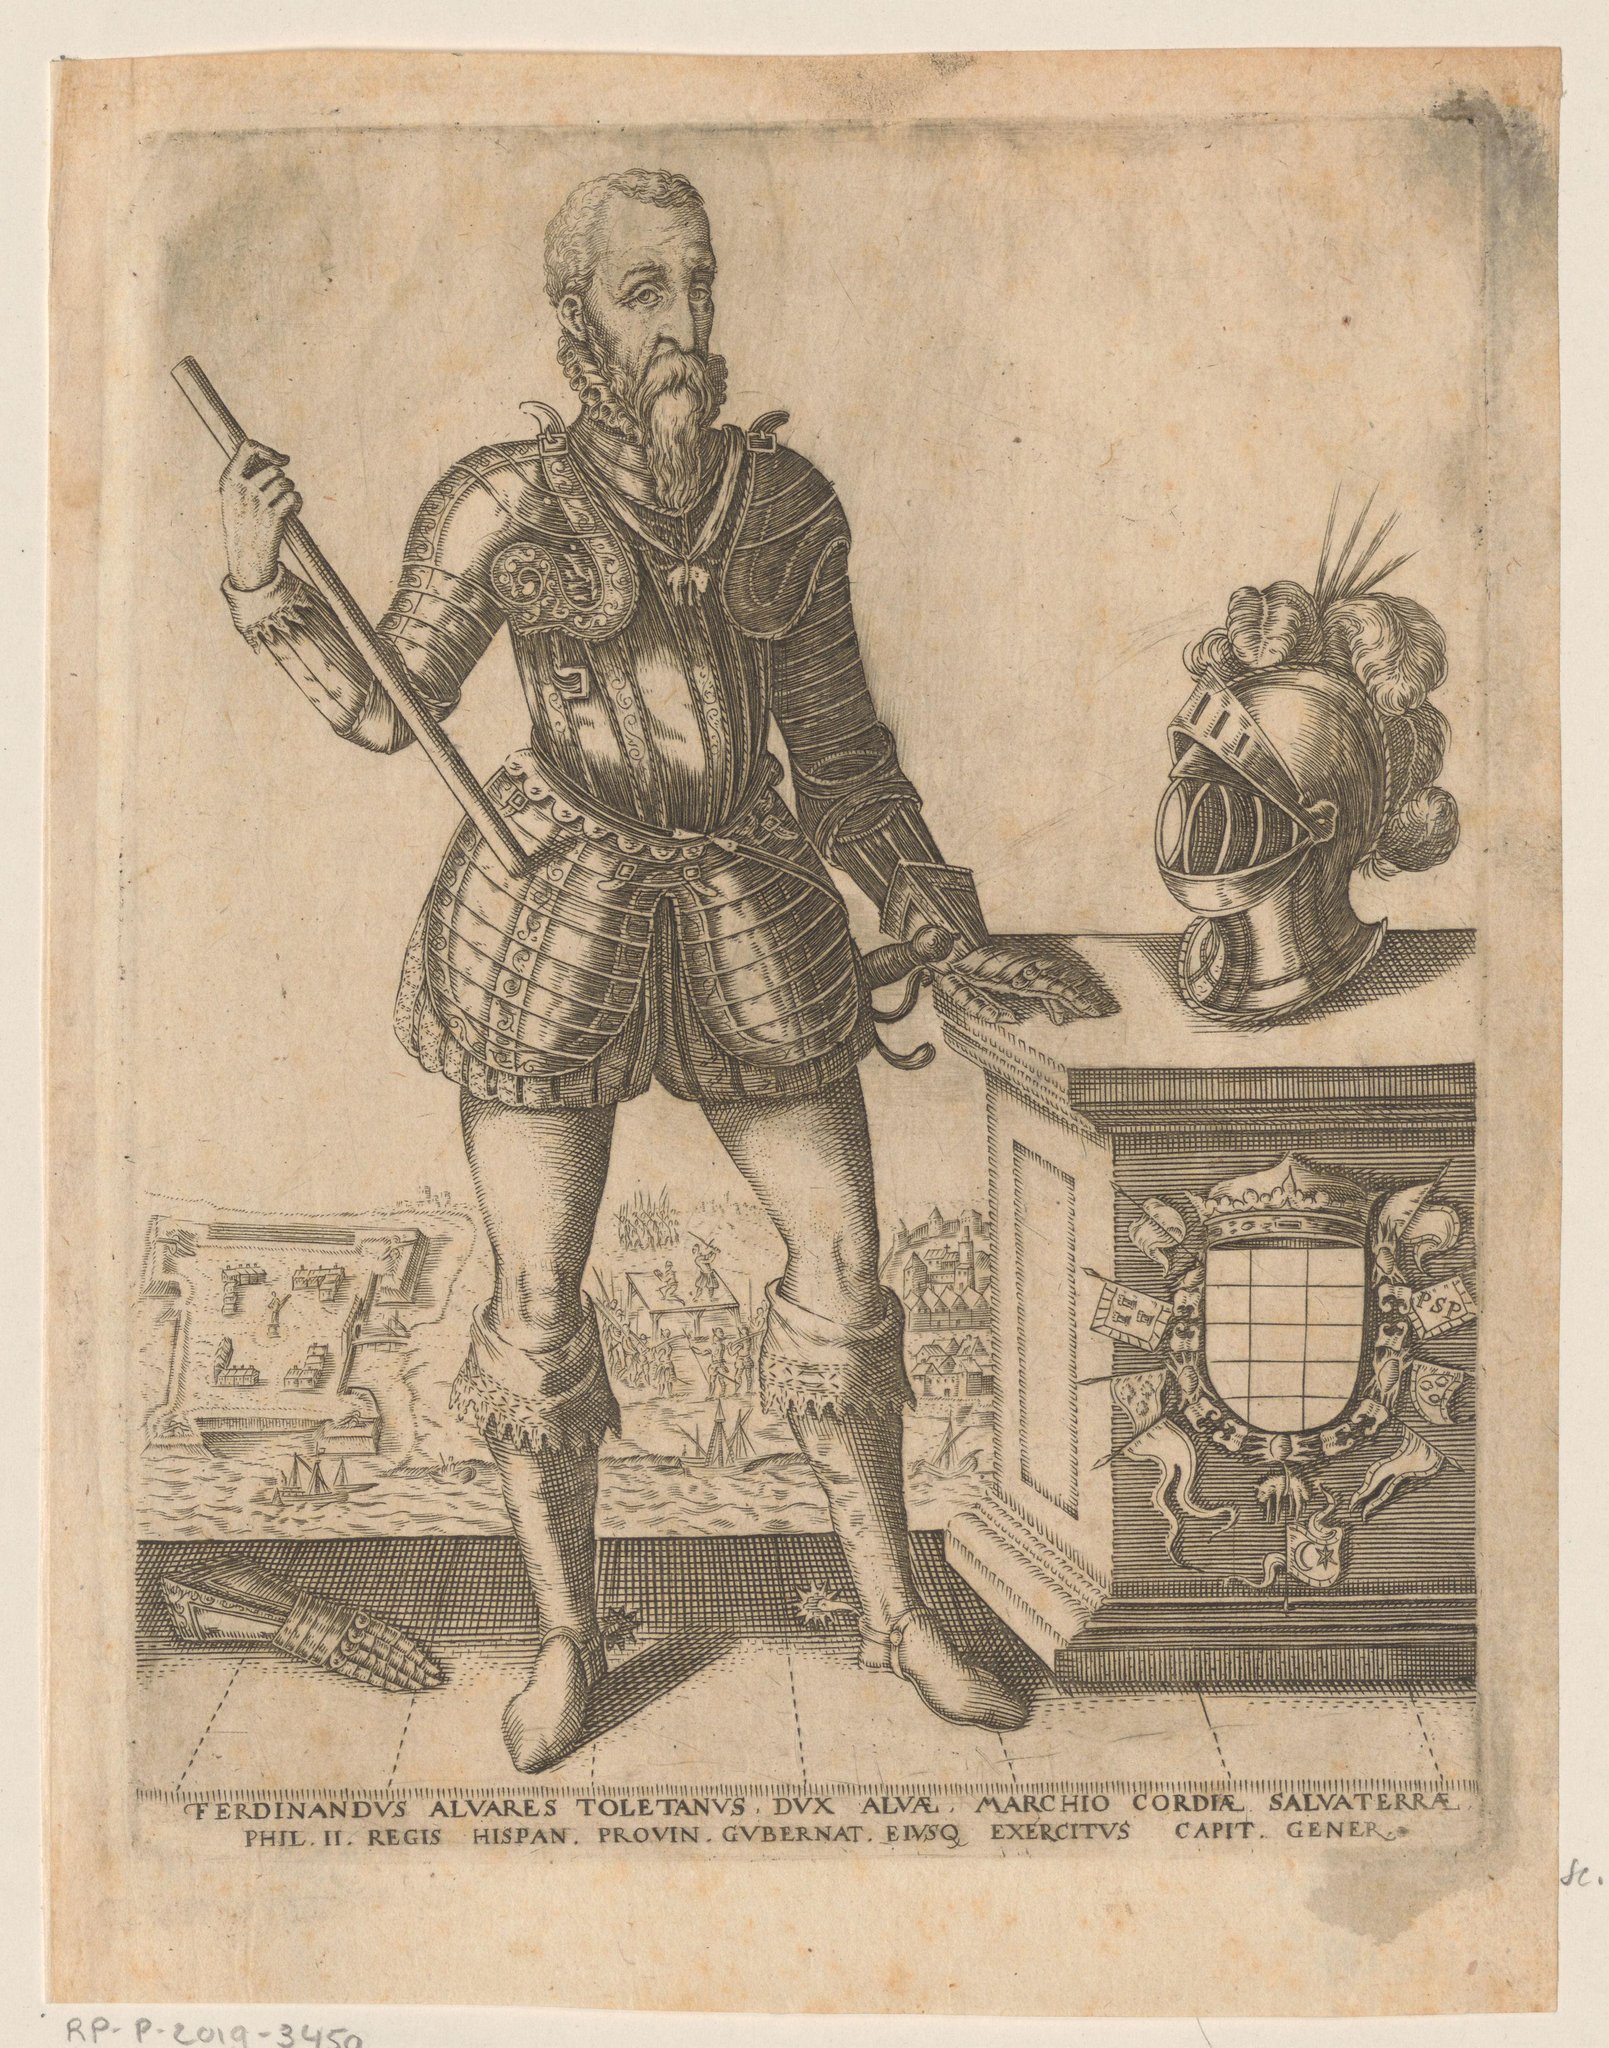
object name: print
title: Portret van Fernando Álvarez de Toledo, hertog van Alva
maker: christoffel van sichem (i)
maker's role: print maker, publisher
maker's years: 1546-1624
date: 1611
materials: paper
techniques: engraving, etching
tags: fernando álvarez de toledo (3rd duke of alba), helmet, city-view, and landscape with man-made constructions, armour, historical persons, on the scaffold or place of execution, knighthood order of the golden fleece - insignia of a knighthood order, e.g.: badge, chain (with name of order), baton of general, armorial bearing, heraldry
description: Met om zijn nek een ketting van de Orde van het Gulden Vlies.